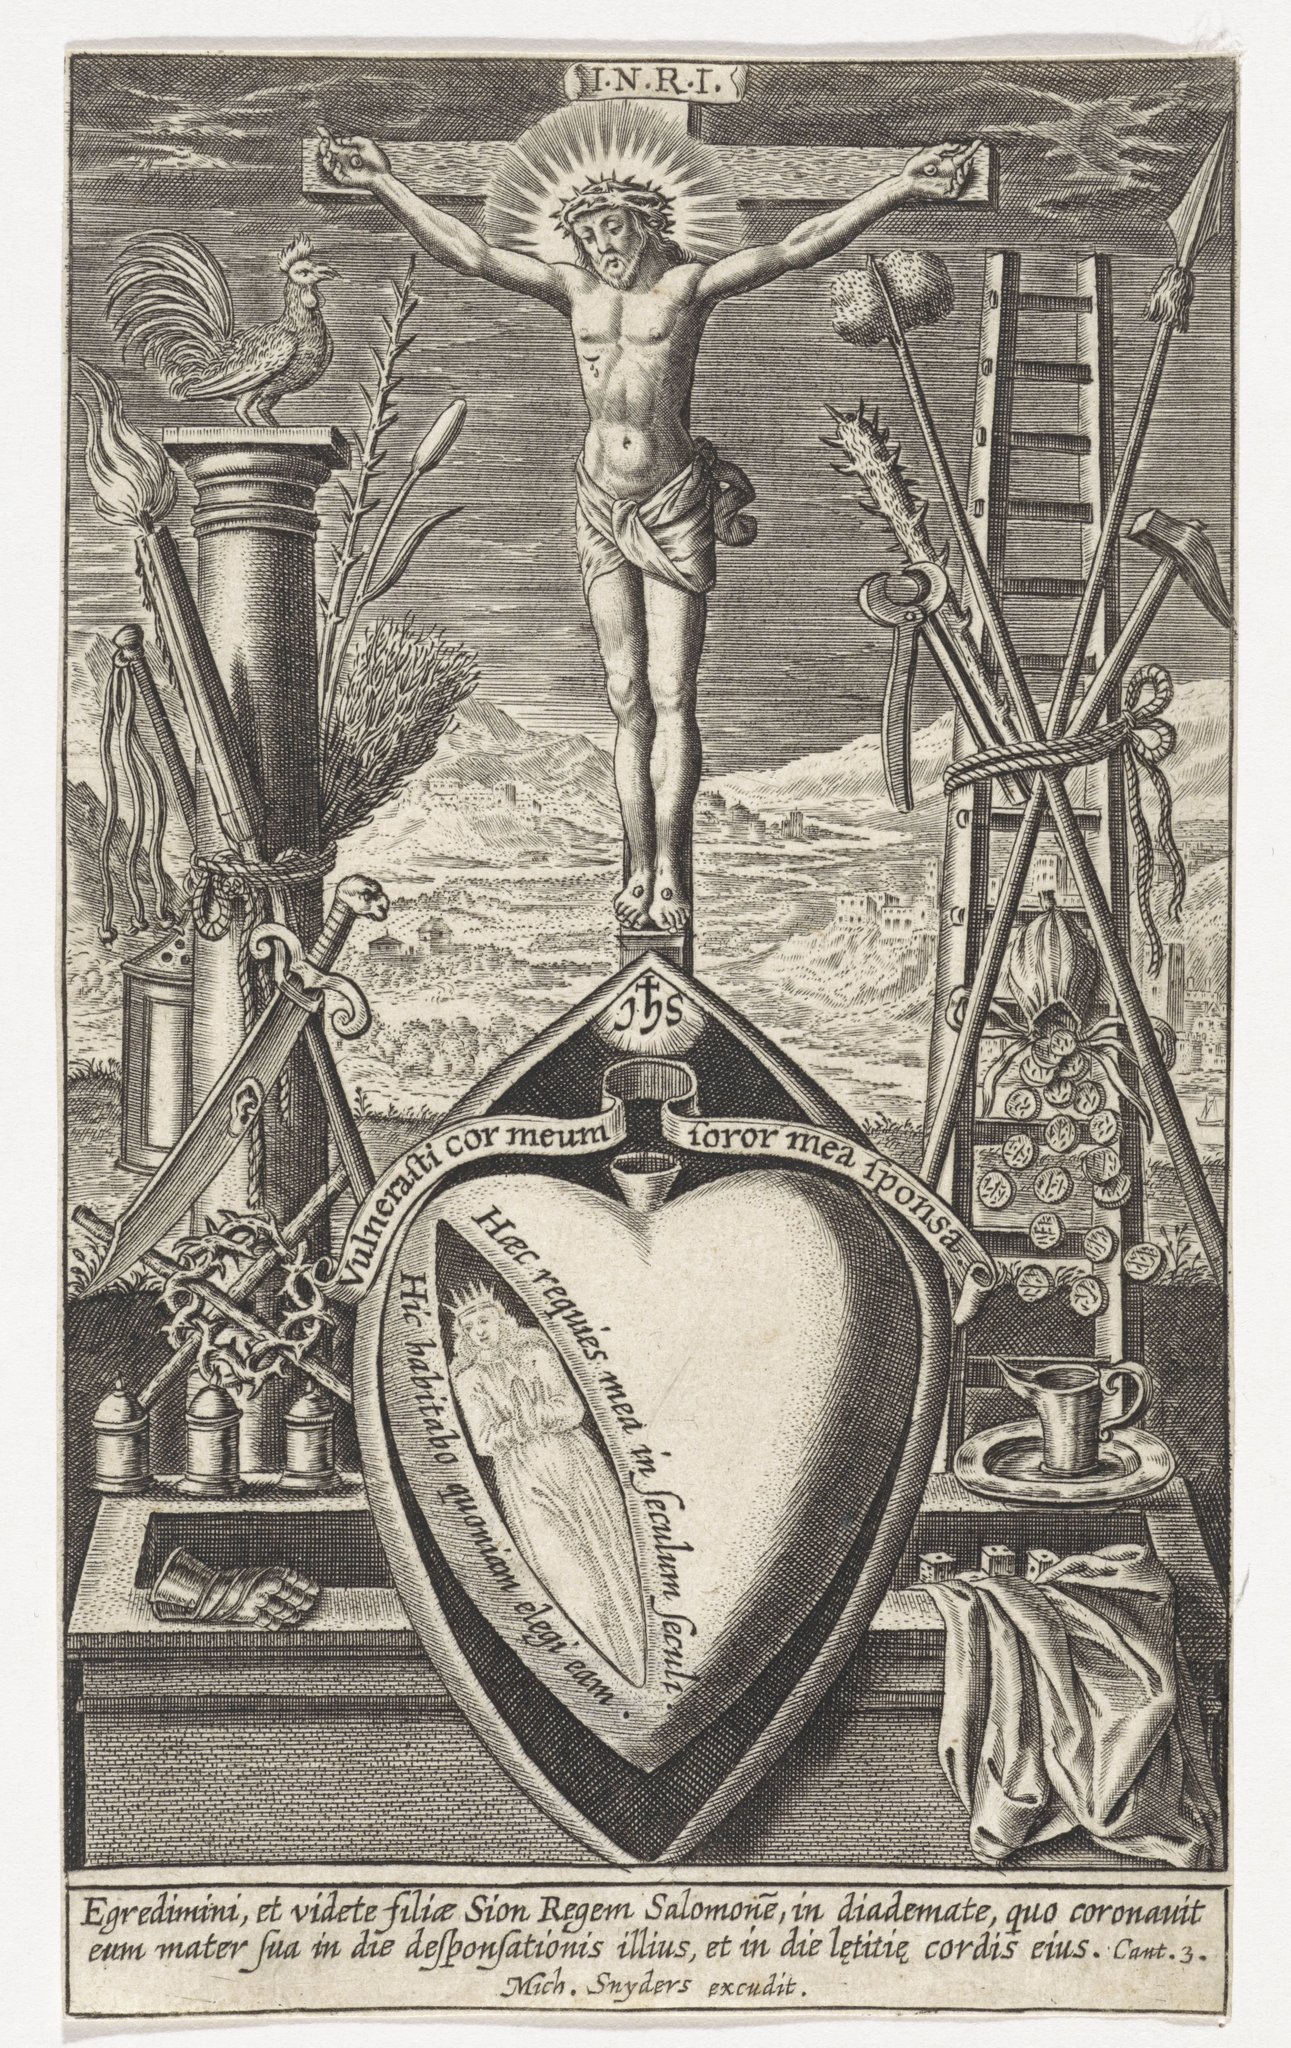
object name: print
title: Maria, in geopend hart, bij graf van Christus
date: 1610-1672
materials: paper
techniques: engraving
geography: antwerp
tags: (architectonic) structure representing or symbolizing the holy sepulchre, heart symbolism, the virgin mary, the instruments of the passion and the five wounded limbs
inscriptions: collector's mark: Lugt 2228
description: De gekroonde Maria ligt in een opening van een hart, dat tegen het geopende graf van Christus rust. Rond de opening twee regels, en boven het hart in een banderol een regel, allen in het Latijn. Boven de tombe hangt Christus aan het kruis. Aan weerszijden twee pilaren die zijn opgebouwd uit diverse passiewerktuigen. Op de achtergrond een gezicht op een bergachtig landschap. In de marge een tweeregelig Bijbelcitaat uit Hoogl. 3 in het Latijn.